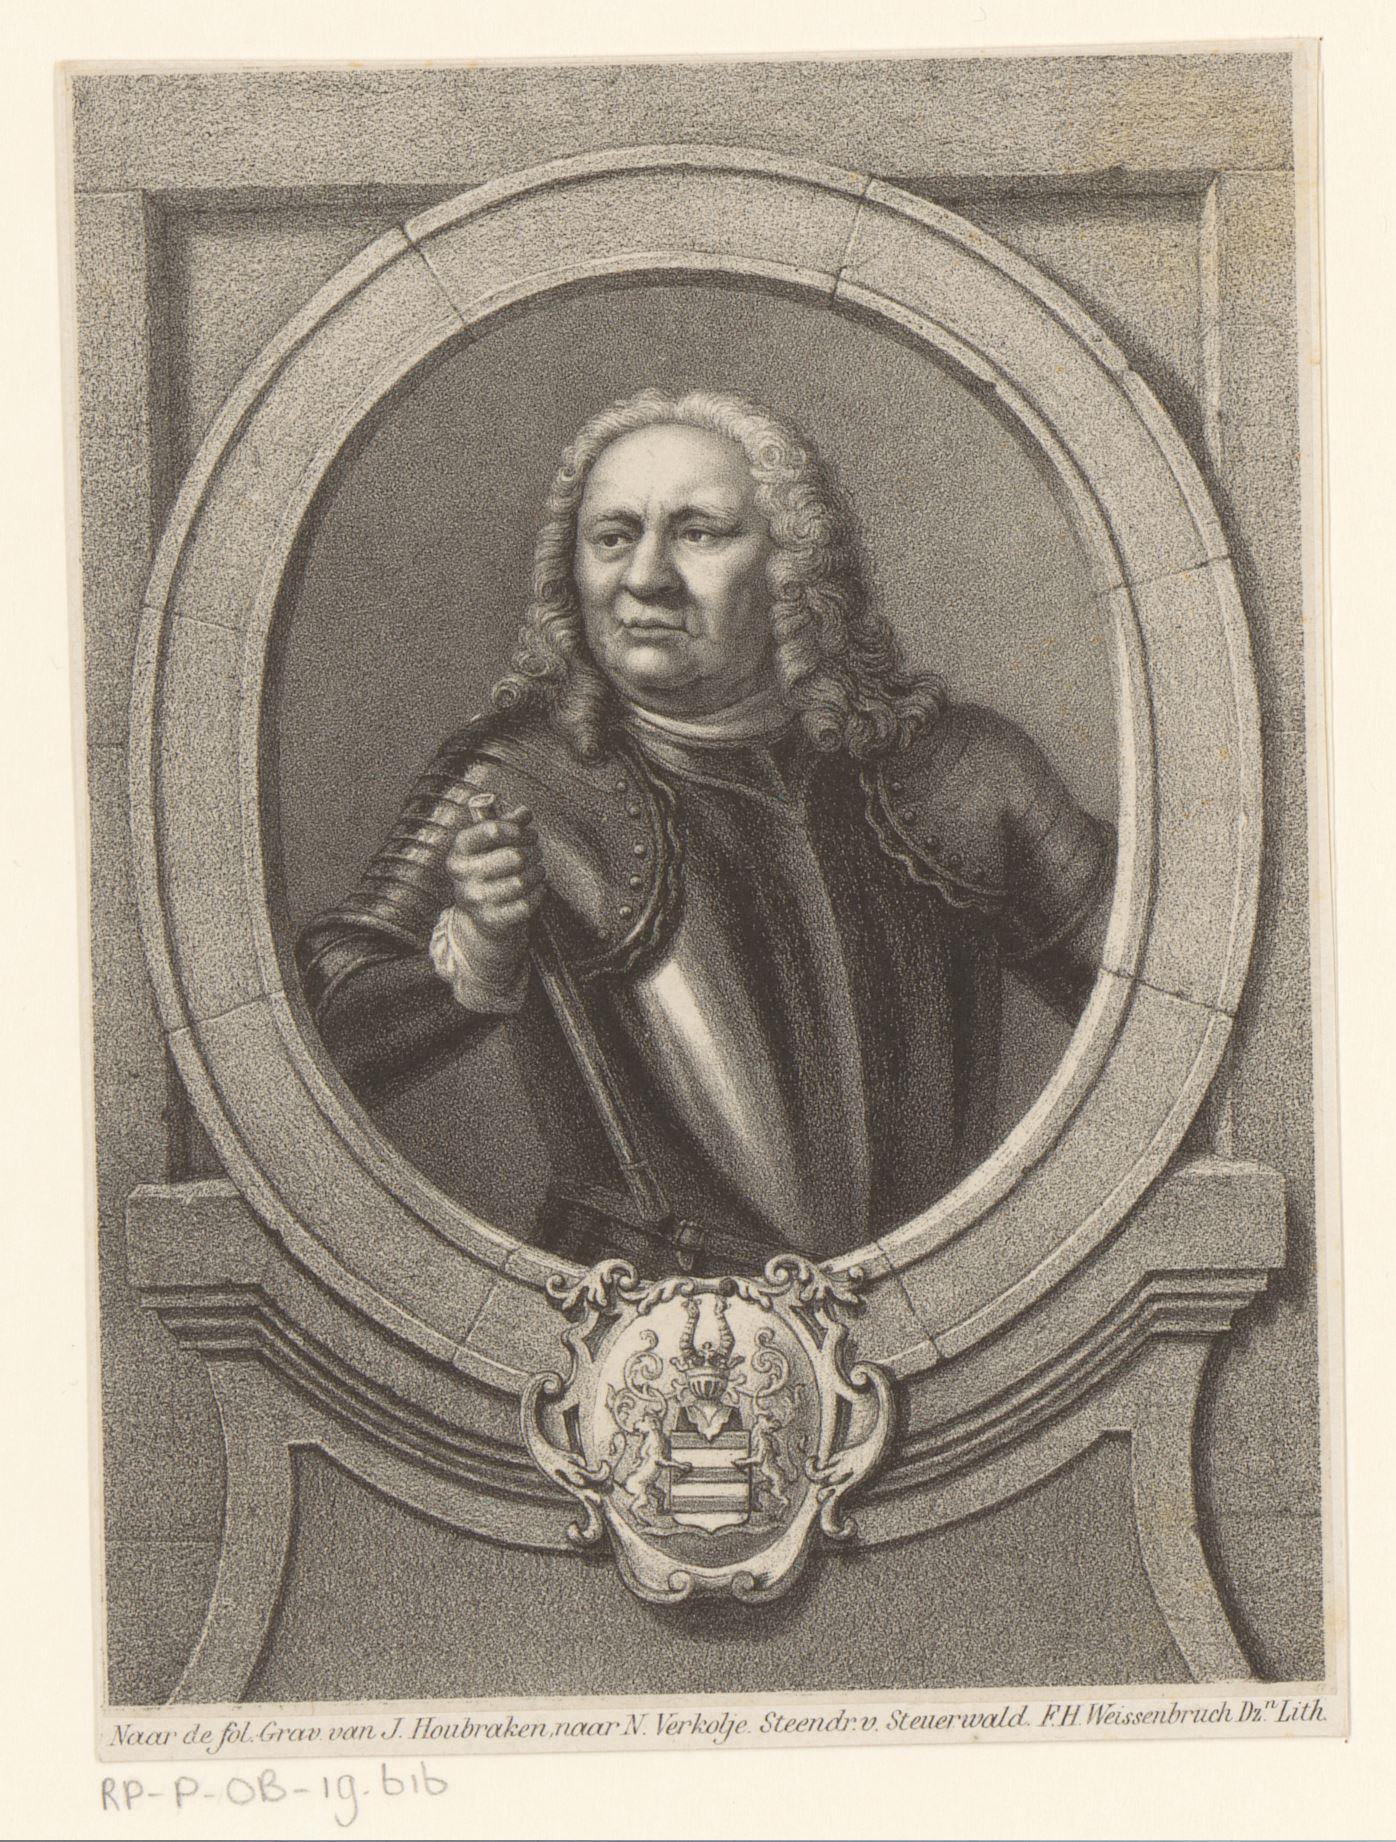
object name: book illustration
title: Portret van Hendrik Grave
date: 1858-1862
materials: paper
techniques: lithograph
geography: the hague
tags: amsterdam, historical persons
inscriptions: collector's mark: Lugt 2228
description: Prent uit: Jonge, J.C. de. Geschiedenis van het Nederlandsche zeewezen. Haarlem: Jonge, J.K.J. de, 1858-62.